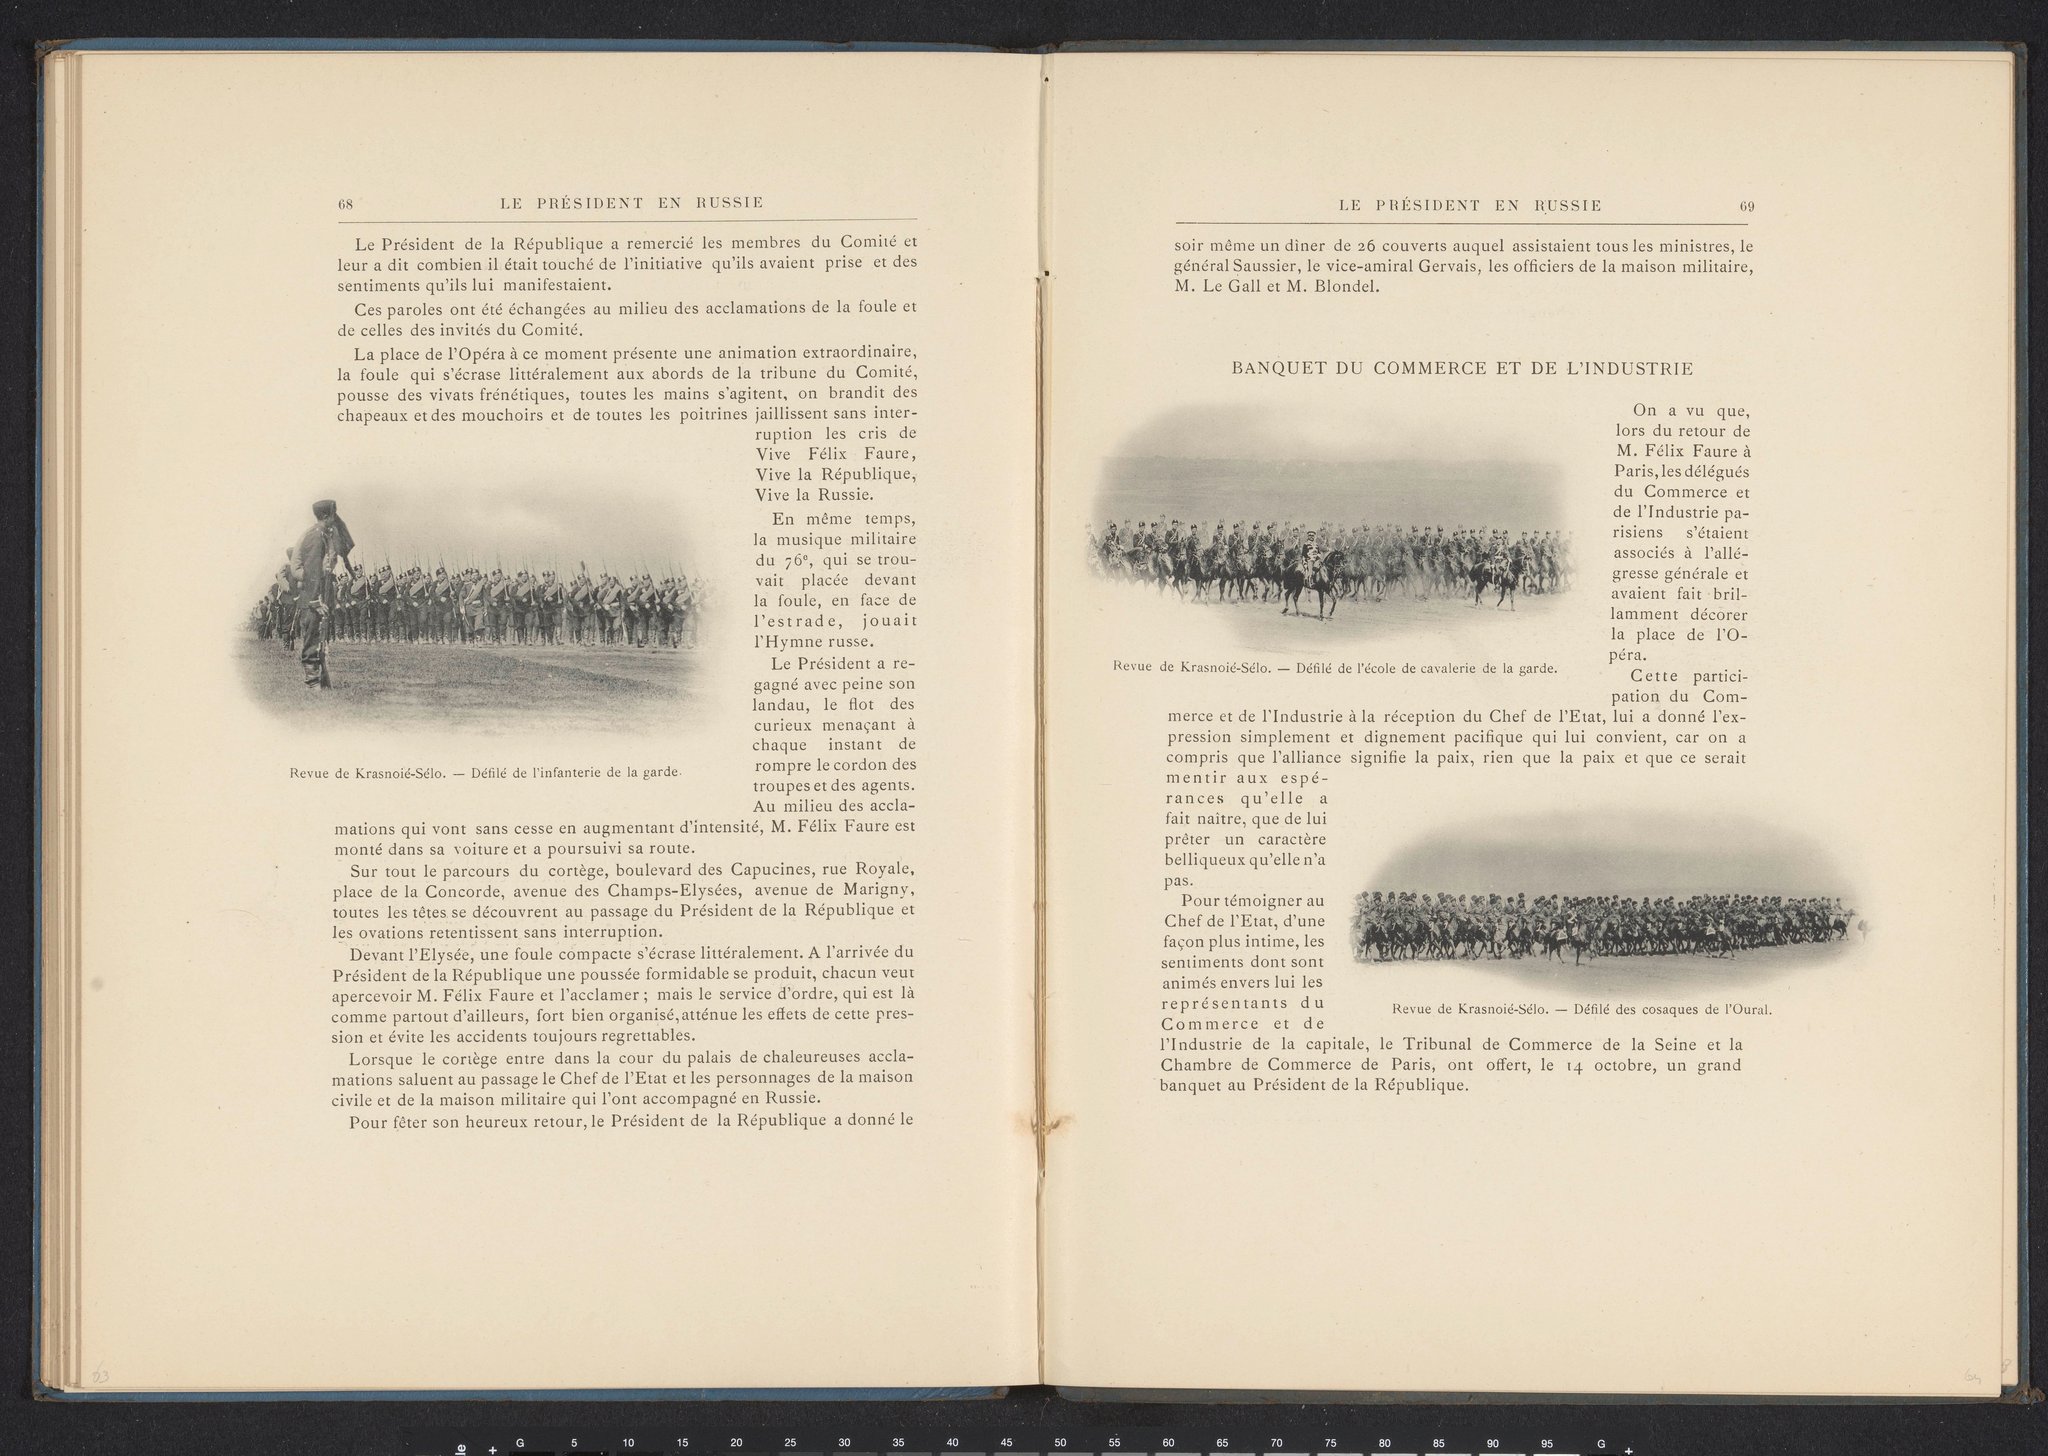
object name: page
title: Defilé van infanteristen te Krasnoye Selo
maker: Anonymous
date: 1897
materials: paper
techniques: photograph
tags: military parade, pageant (+ infantry)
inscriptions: inscription: ‘Revue de Krasnoié-Sélo-(...) de la garde.’